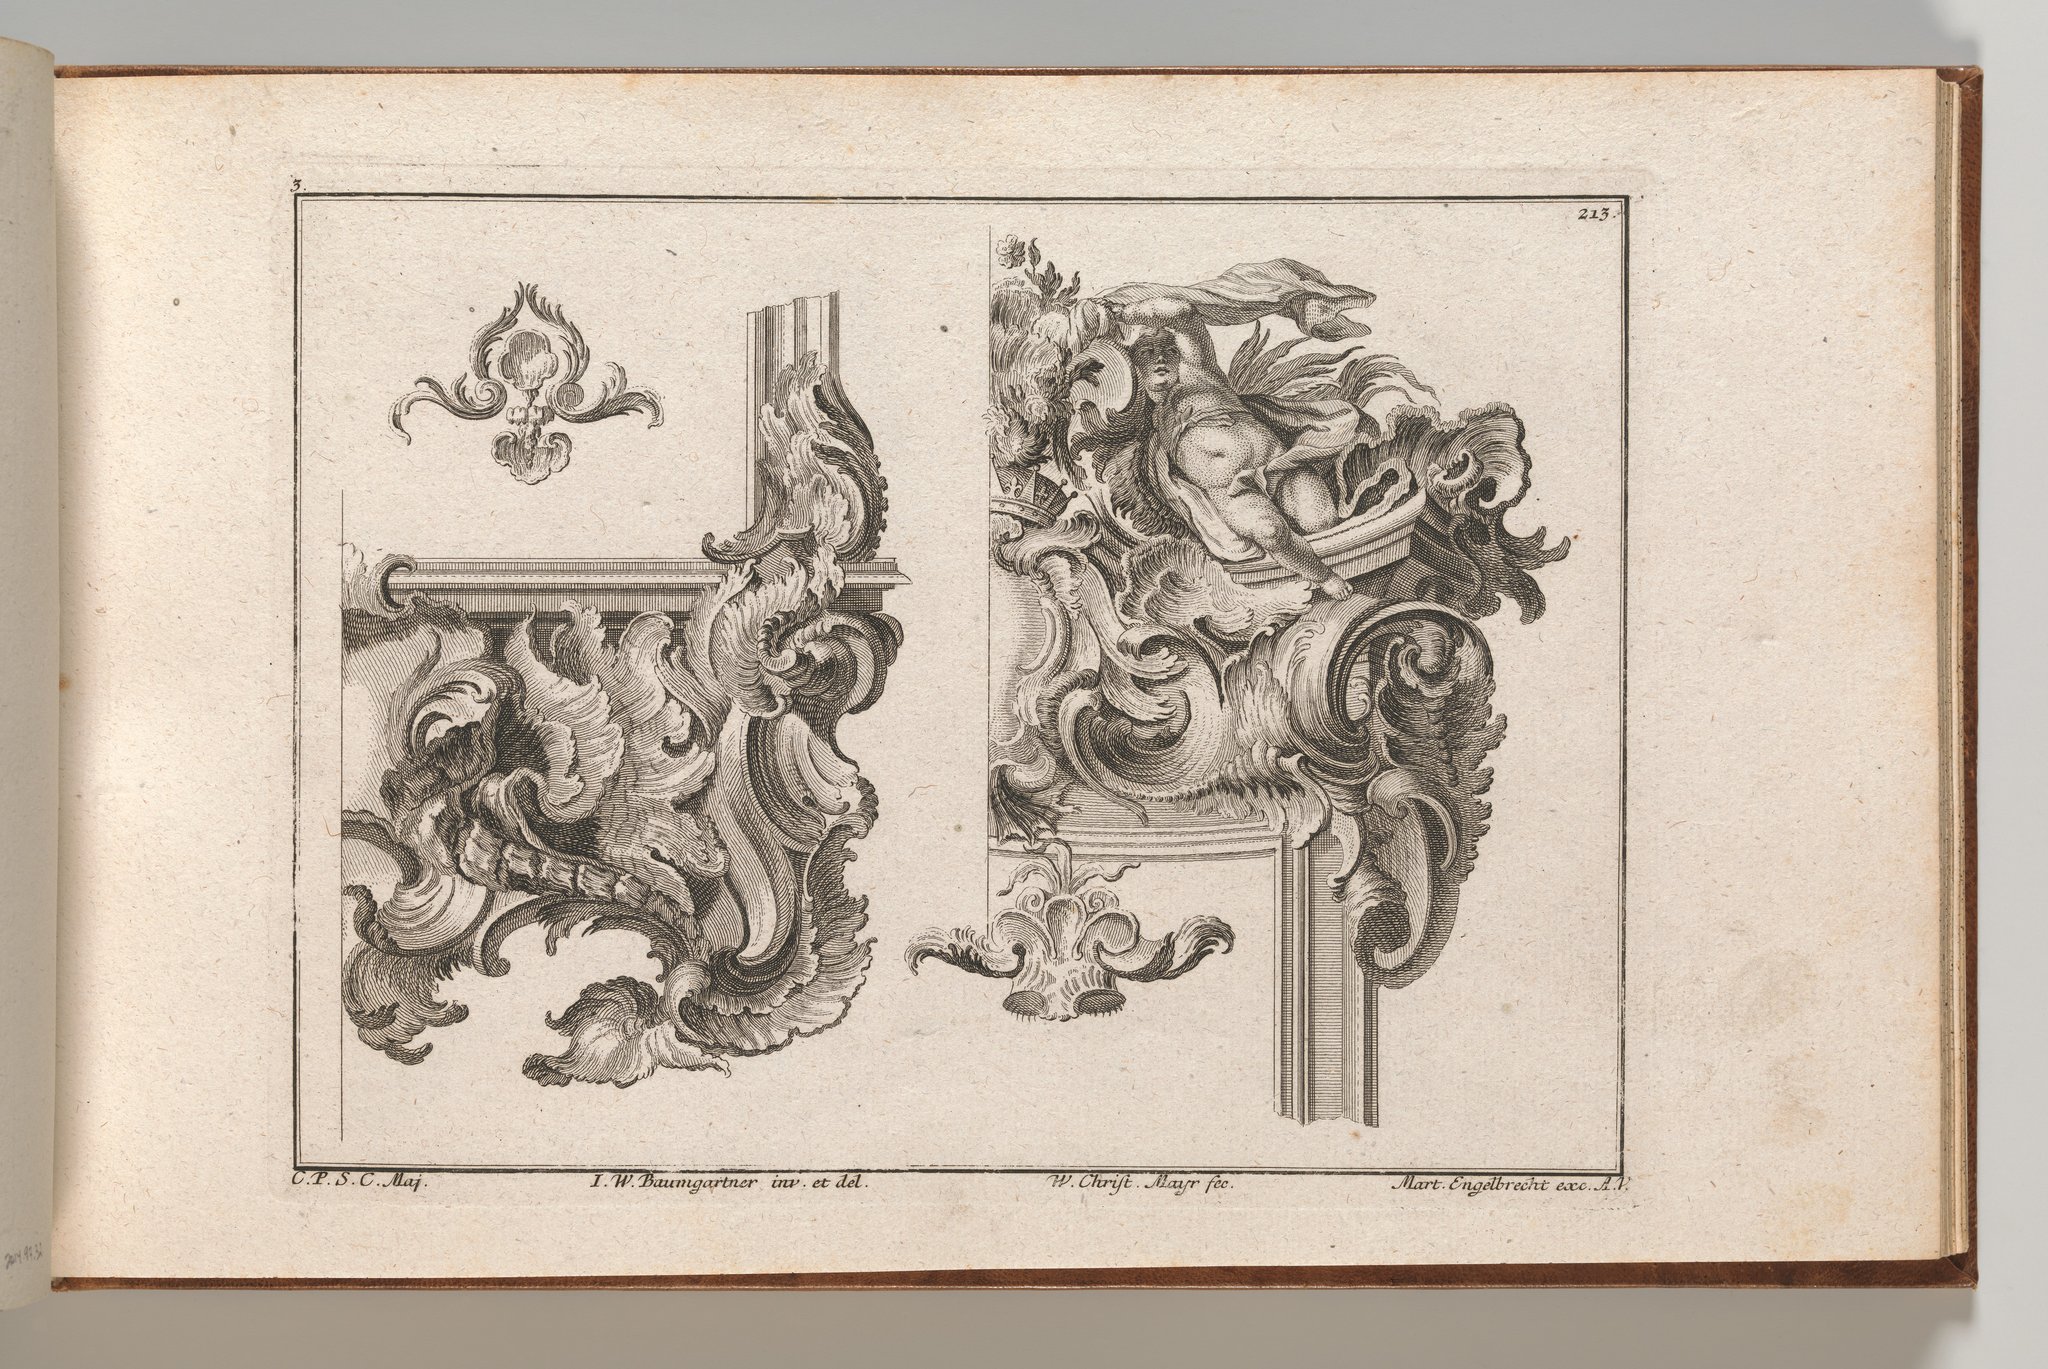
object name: album print ornament architecture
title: Suggestion for the Decoration of Lower Right and Top Right of an Altar Frame, Plate 3 from an Untitled Series with Rocailles Ornaments for Altar and Door Frames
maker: wolffgang christoph mayr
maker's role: engraver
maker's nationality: central european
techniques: etching